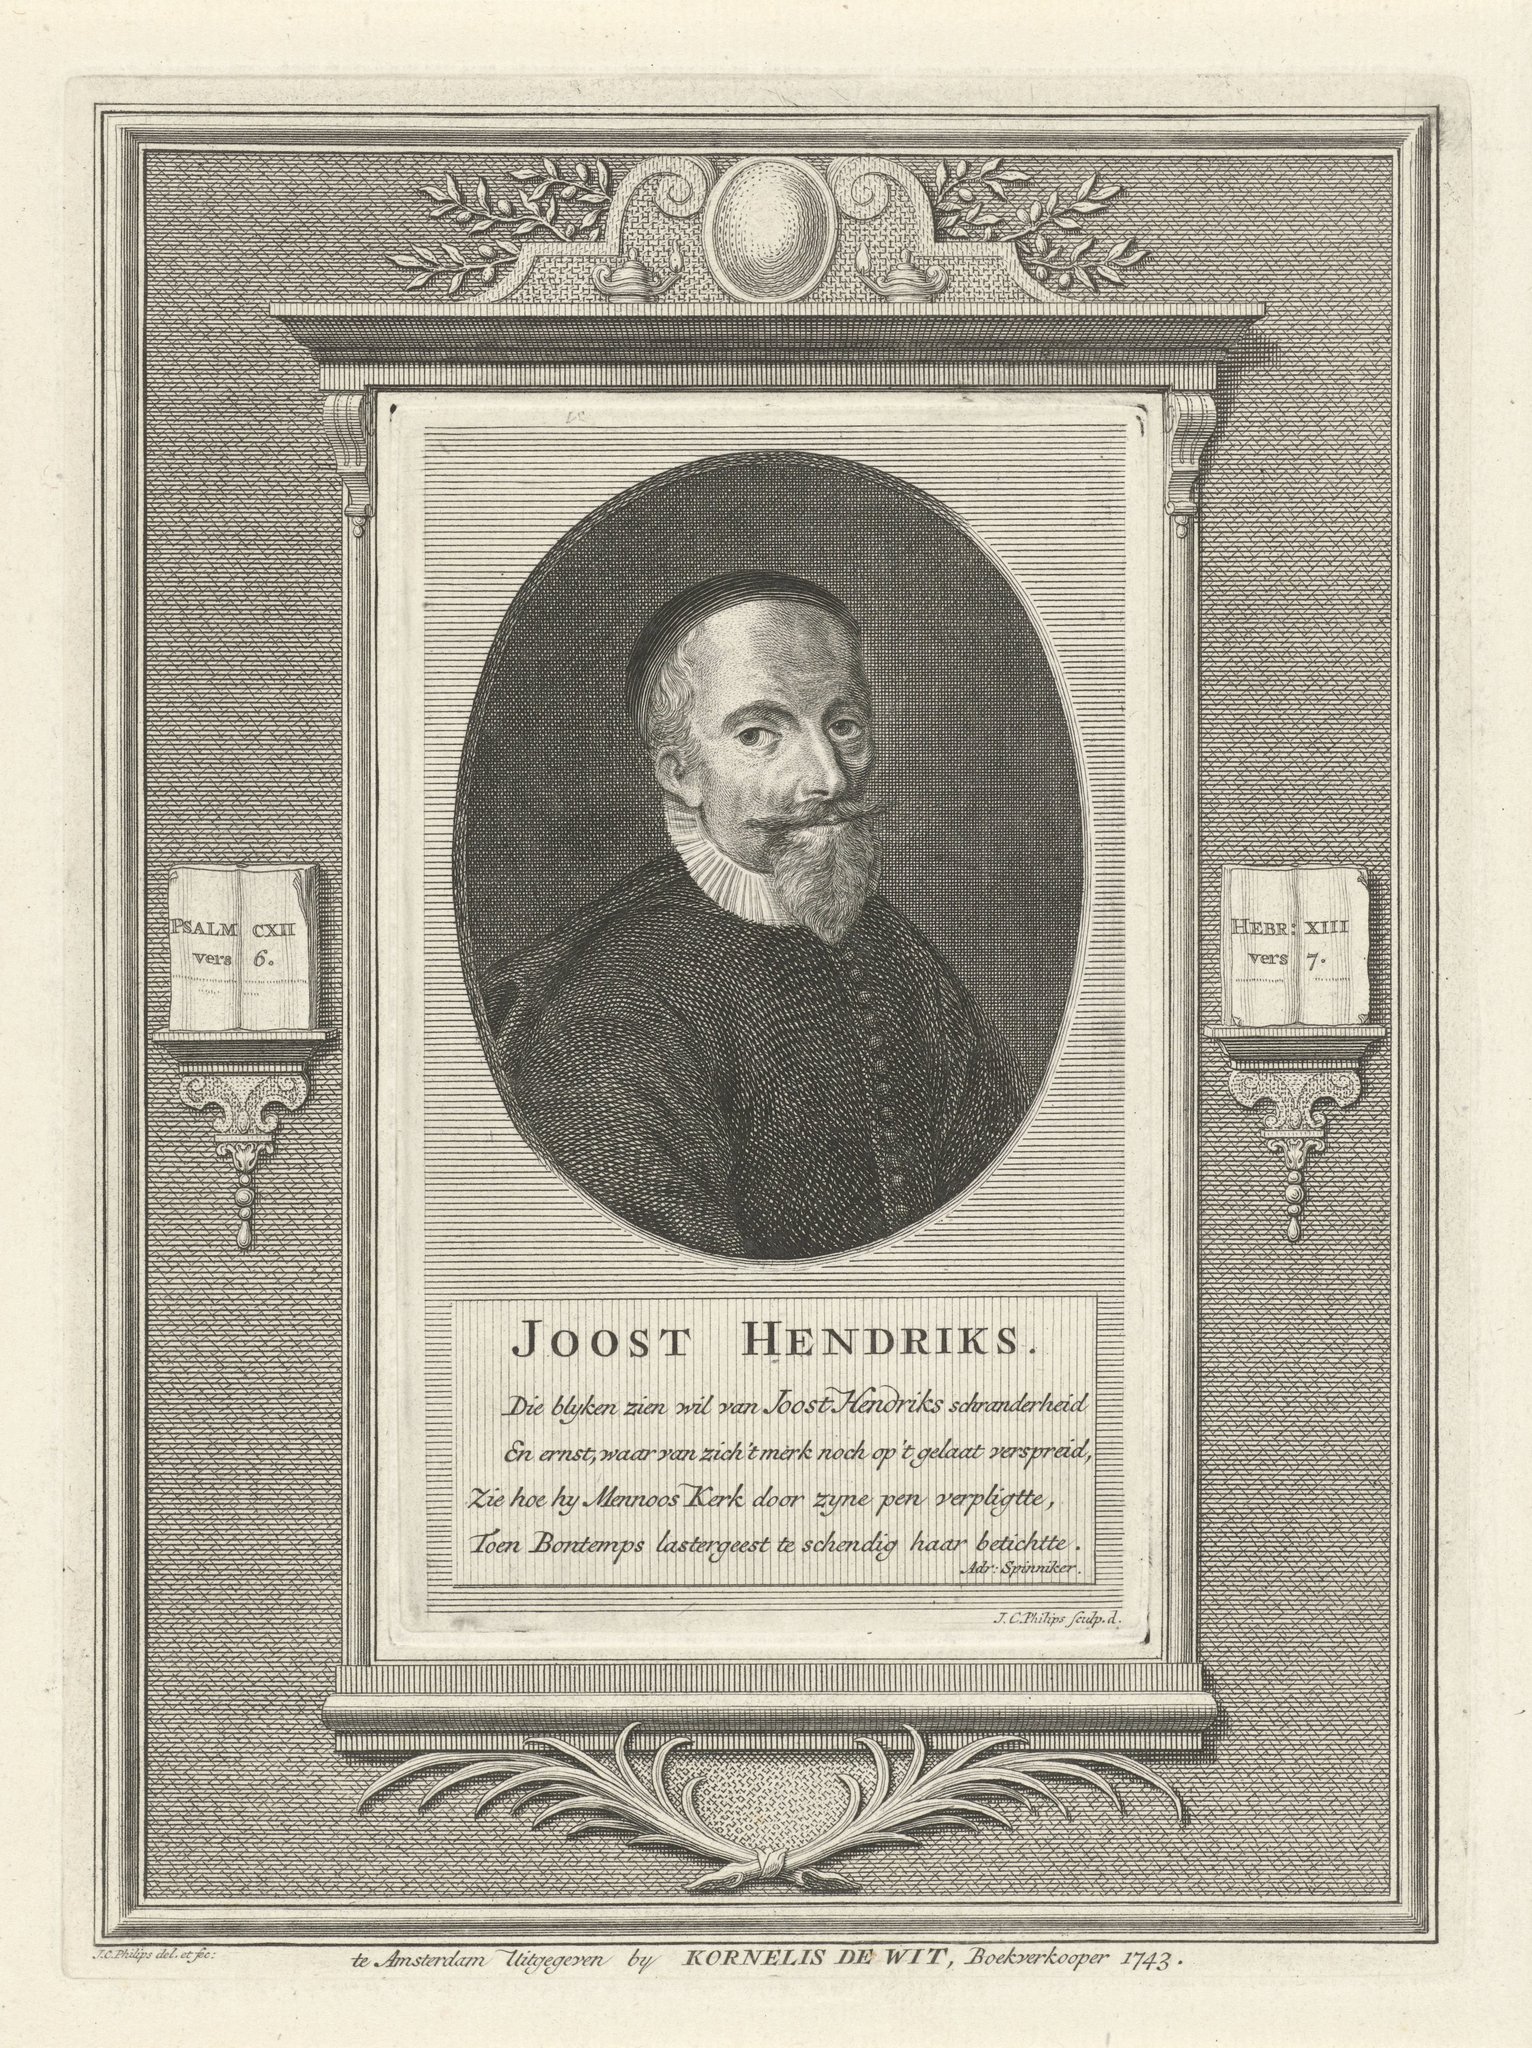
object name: print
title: Portret van de doopsgezinde predikant Joost Hendriksz.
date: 1743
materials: paper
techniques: engraving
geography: amsterdam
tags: harlingen, the bible as a book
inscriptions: collector's mark: Lugt 2228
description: Prent als illustratie gebruikt in: Verzaameling van de afbeeldingen van veele voornaame mannen en leeraaren, die (...) het leeraars ampt onder de doopsgezinde christenen bediend hebben. Amsterdam: Kornelis de Wit, 1743.